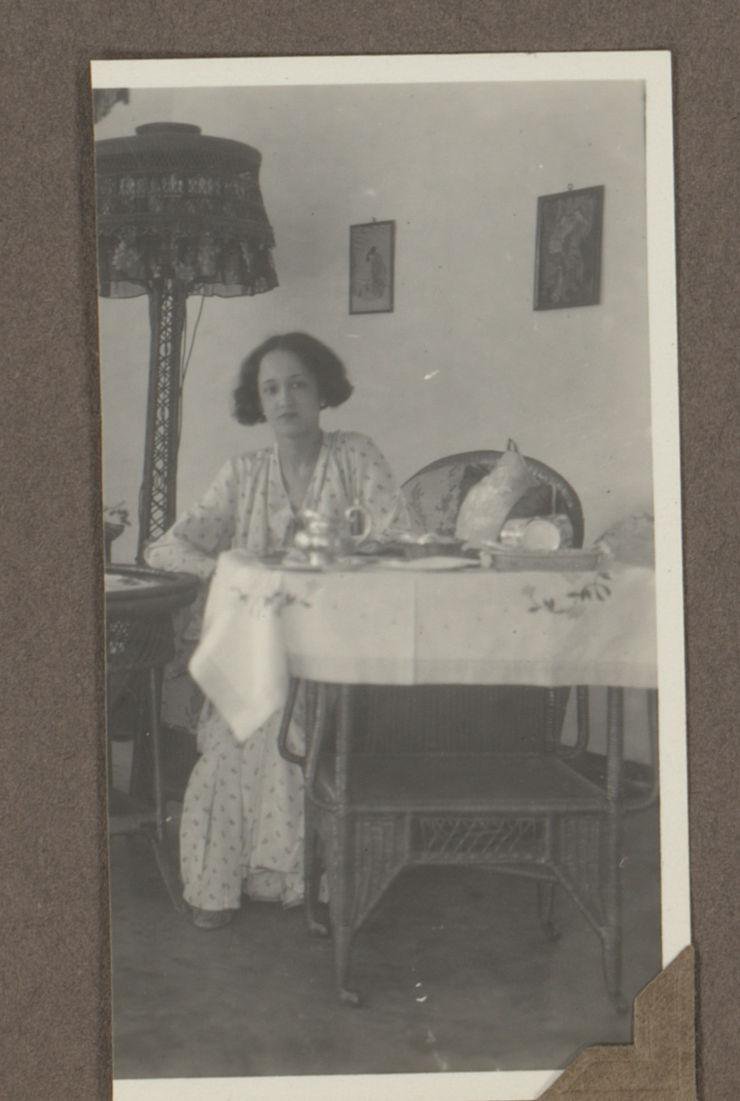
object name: photograph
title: Dootje van Zijll de Jong in een interieur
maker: Anonymous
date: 1930-1935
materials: paper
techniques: gelatin silver print, snipping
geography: dutch east indies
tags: amsterdam, adult woman, dutch east indies, the